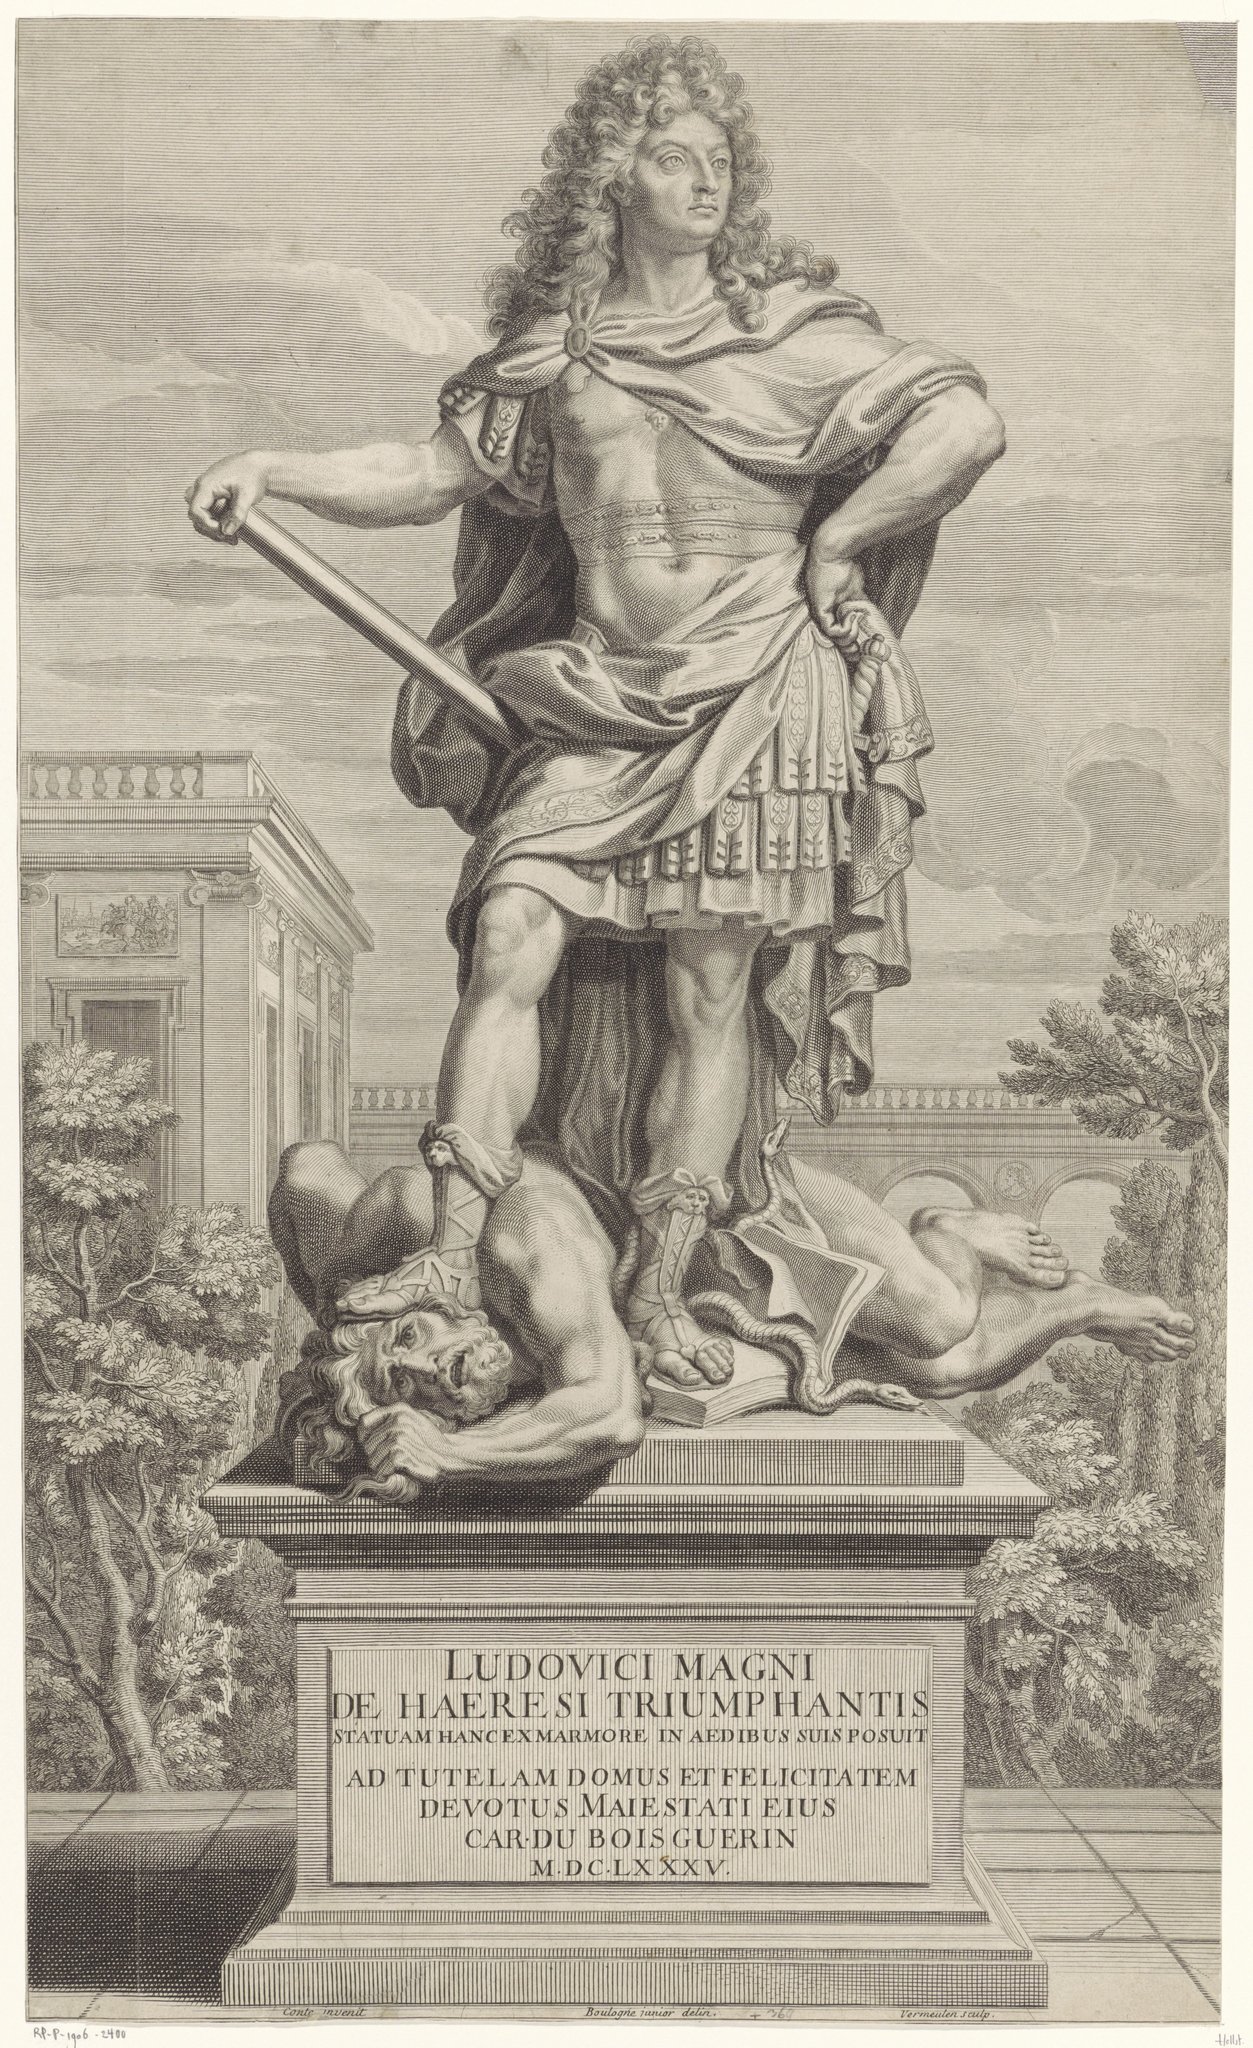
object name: print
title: Standbeeld van Lodewijk XIV die de Ketterij vertrapt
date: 1685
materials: paper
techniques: engraving, etching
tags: lodewijk xiv (koning van frankrijk), false church personified, monument, statue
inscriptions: collector's mark: Lugt 2228